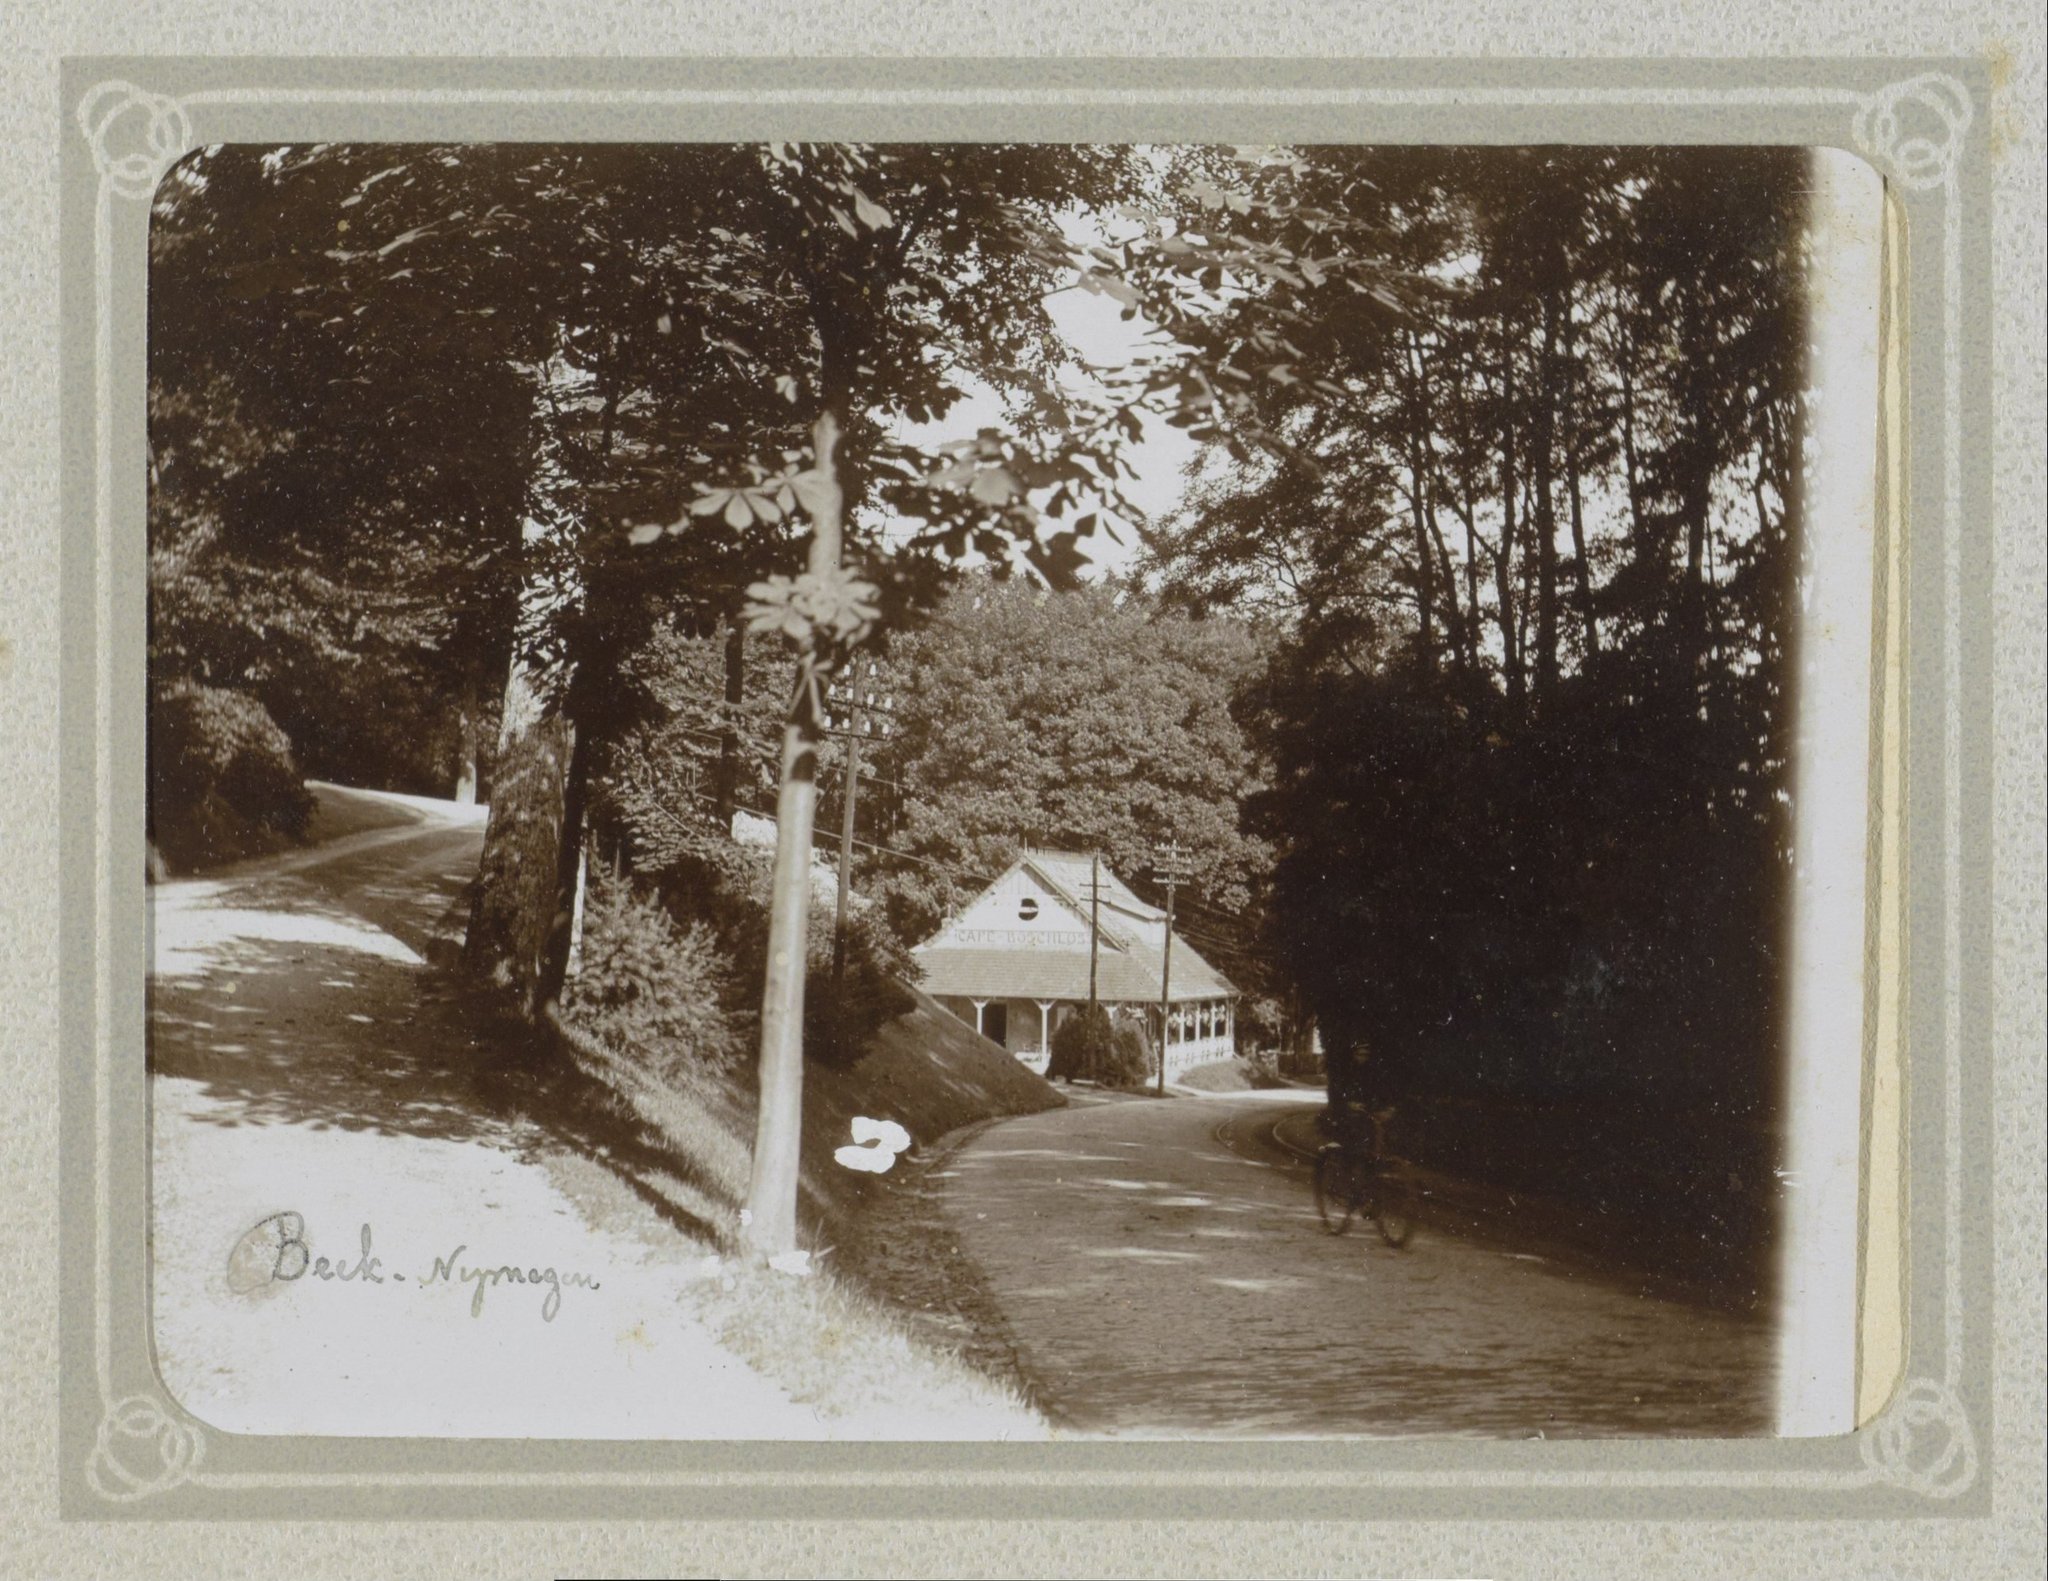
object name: photograph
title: Beek-Nijmegen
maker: folkert idzes de jong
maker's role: architect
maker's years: 1877-1929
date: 1905-1907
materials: photographic support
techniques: collodion silver print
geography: beek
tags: inn, coffee-house, public house, etc., village street, bicycle, meadow, pasture (+ landscape with figures, staffage)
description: Onderdeel van Topografisch album van Nederlandse dorpen en steden 1905.